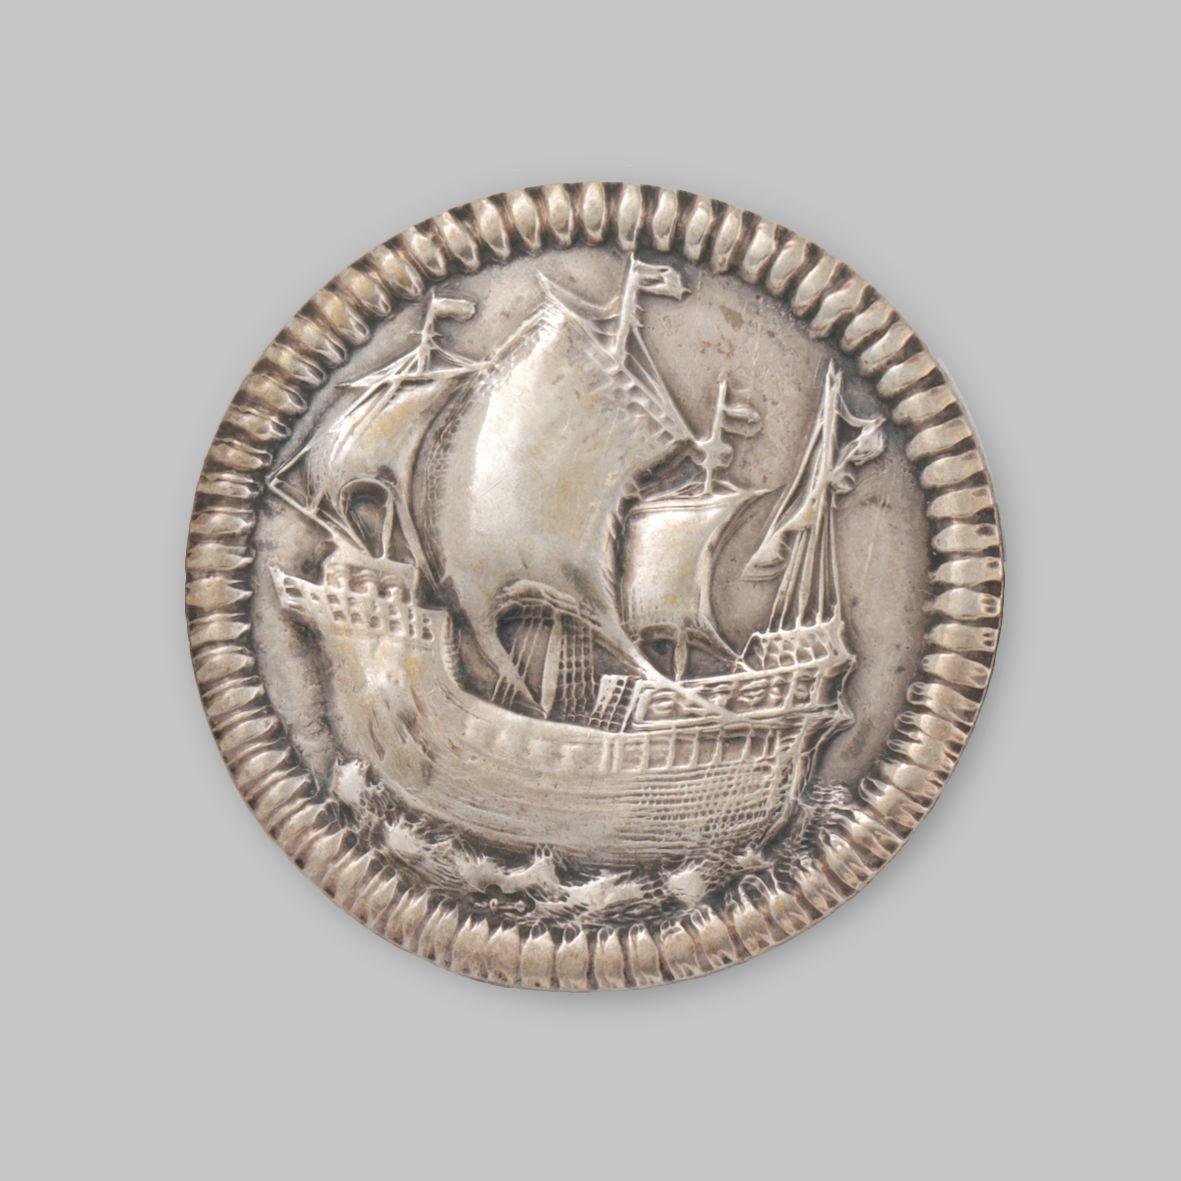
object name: button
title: Knoop met voorstelling van een driemaster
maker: Anonymous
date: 1850-1900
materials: silver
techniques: casting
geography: netherlands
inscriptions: alloy mark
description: Knoop van gegoten zilver, rond, met op de voorzijde een driemaster omgeven door een geribde rand. Aan de achterzijde is een uit gebogen draad vervaardigd oog bevestigd.